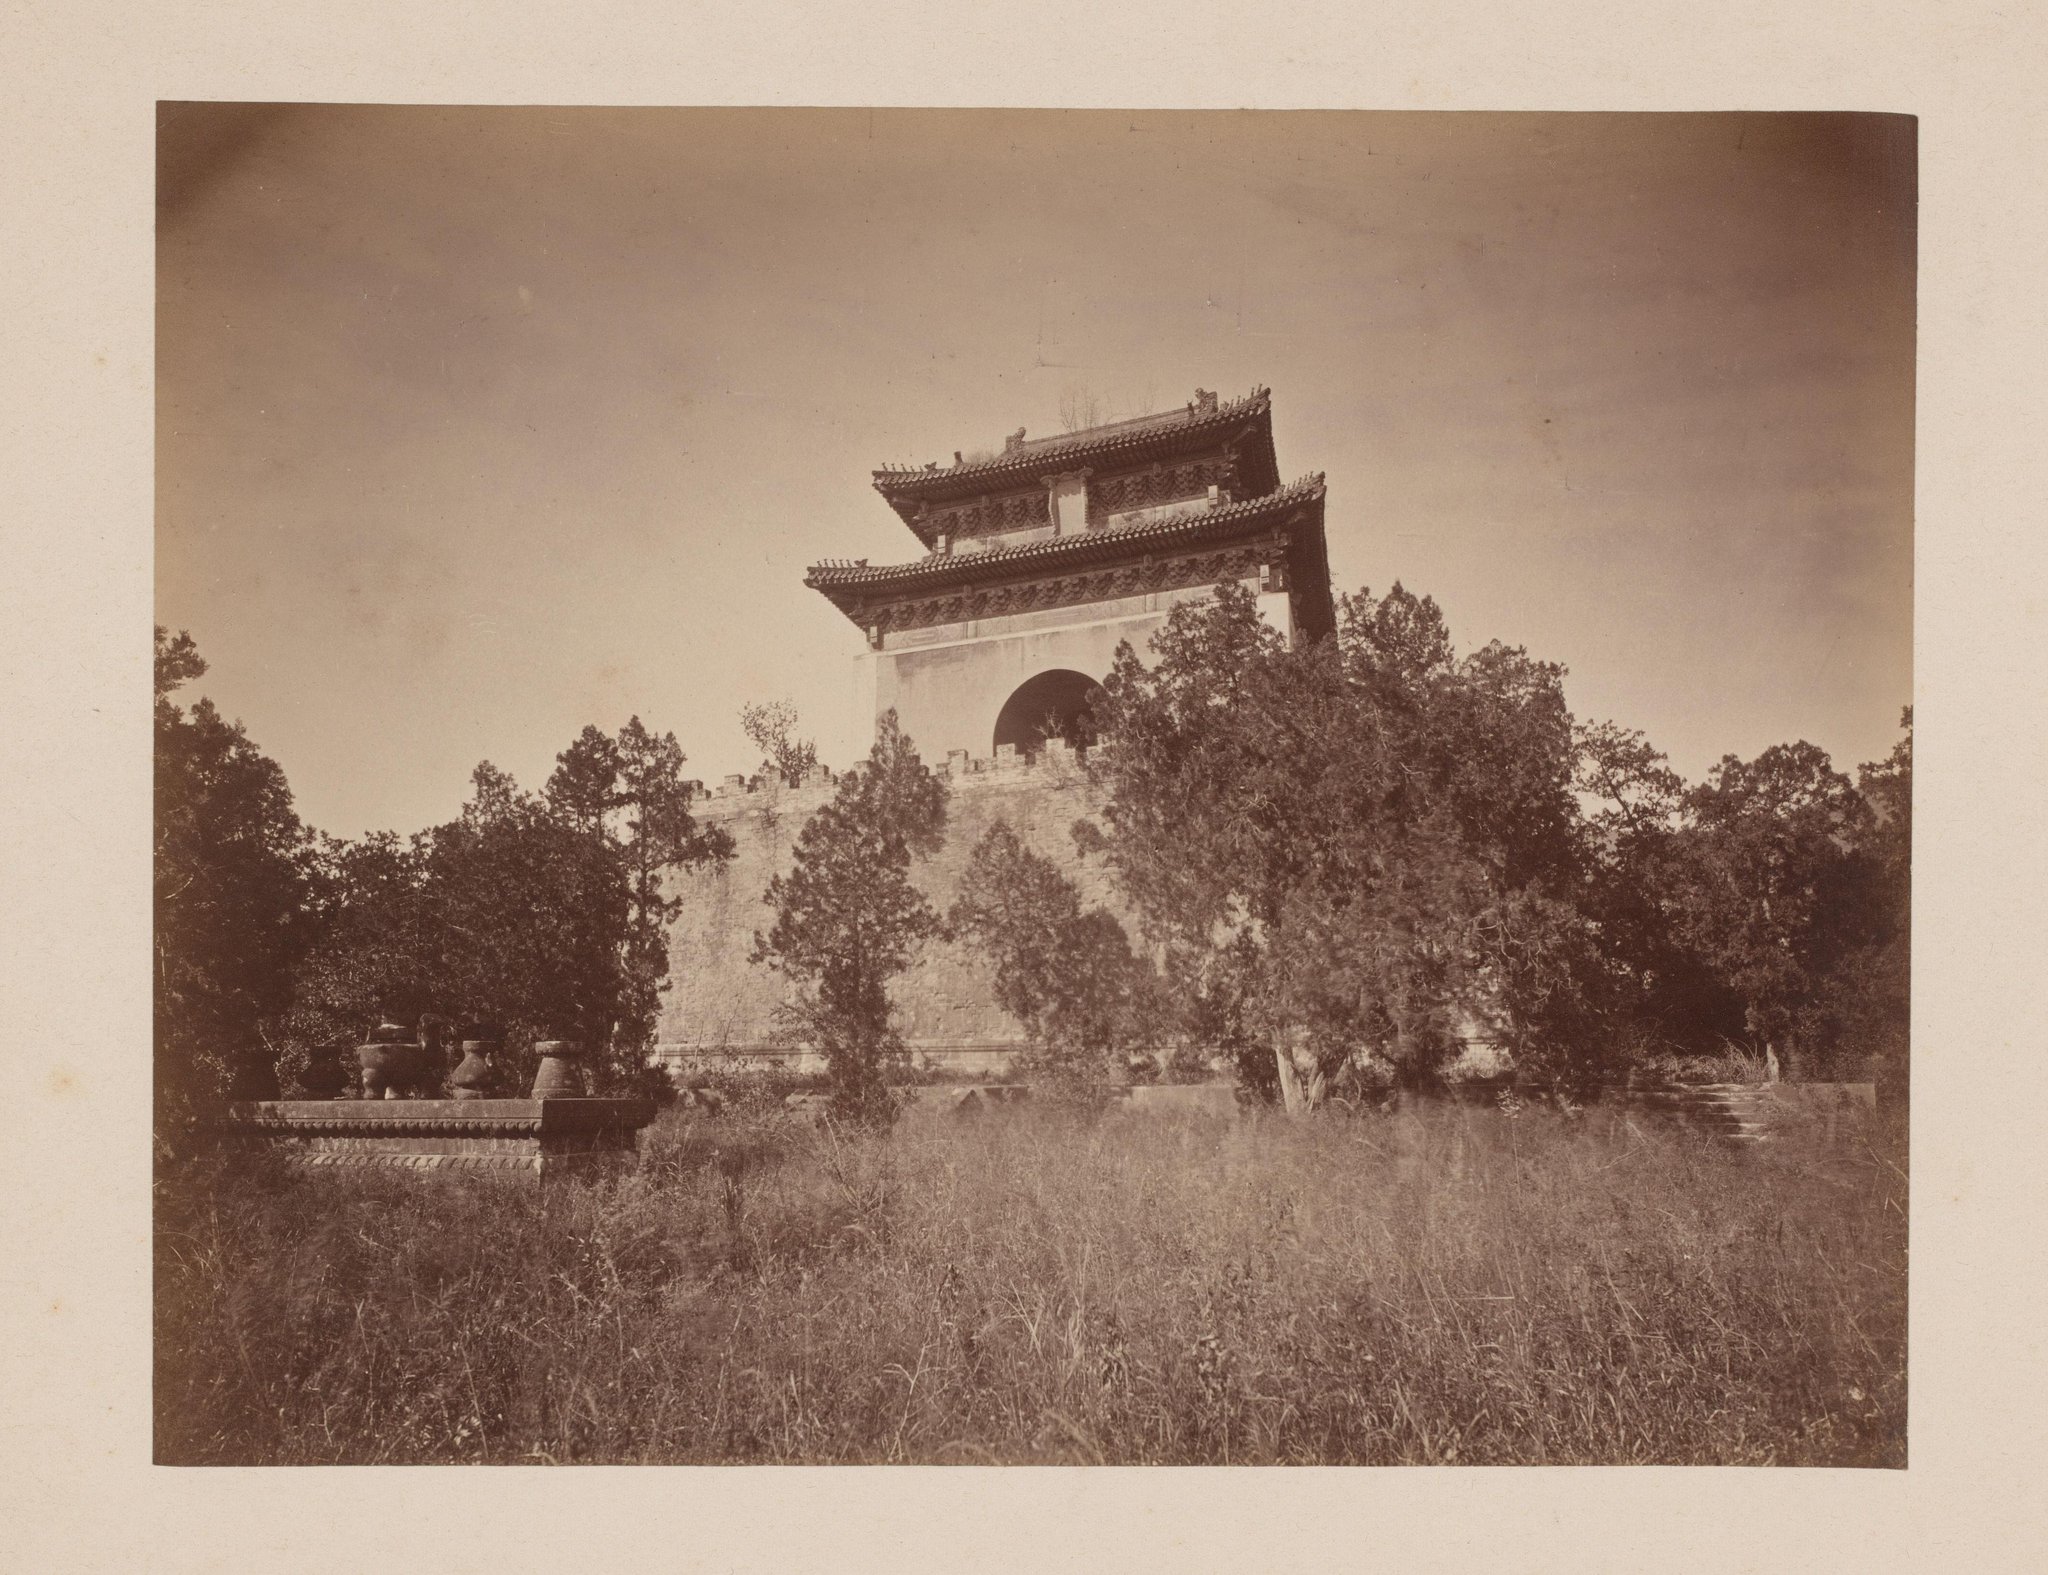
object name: photograph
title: Gezicht op het mausoleum van Yung Lo, onderdeel van de Ming tombes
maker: Anonymous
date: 1860-1900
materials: cardboard, photographic support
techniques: albumen print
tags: mausoleum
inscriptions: annotation: ‘No. 905, The Ming Tombs/ An exterior view of Yng-lo's Mausoleum who was the third monarch of the Ming Dynasty’